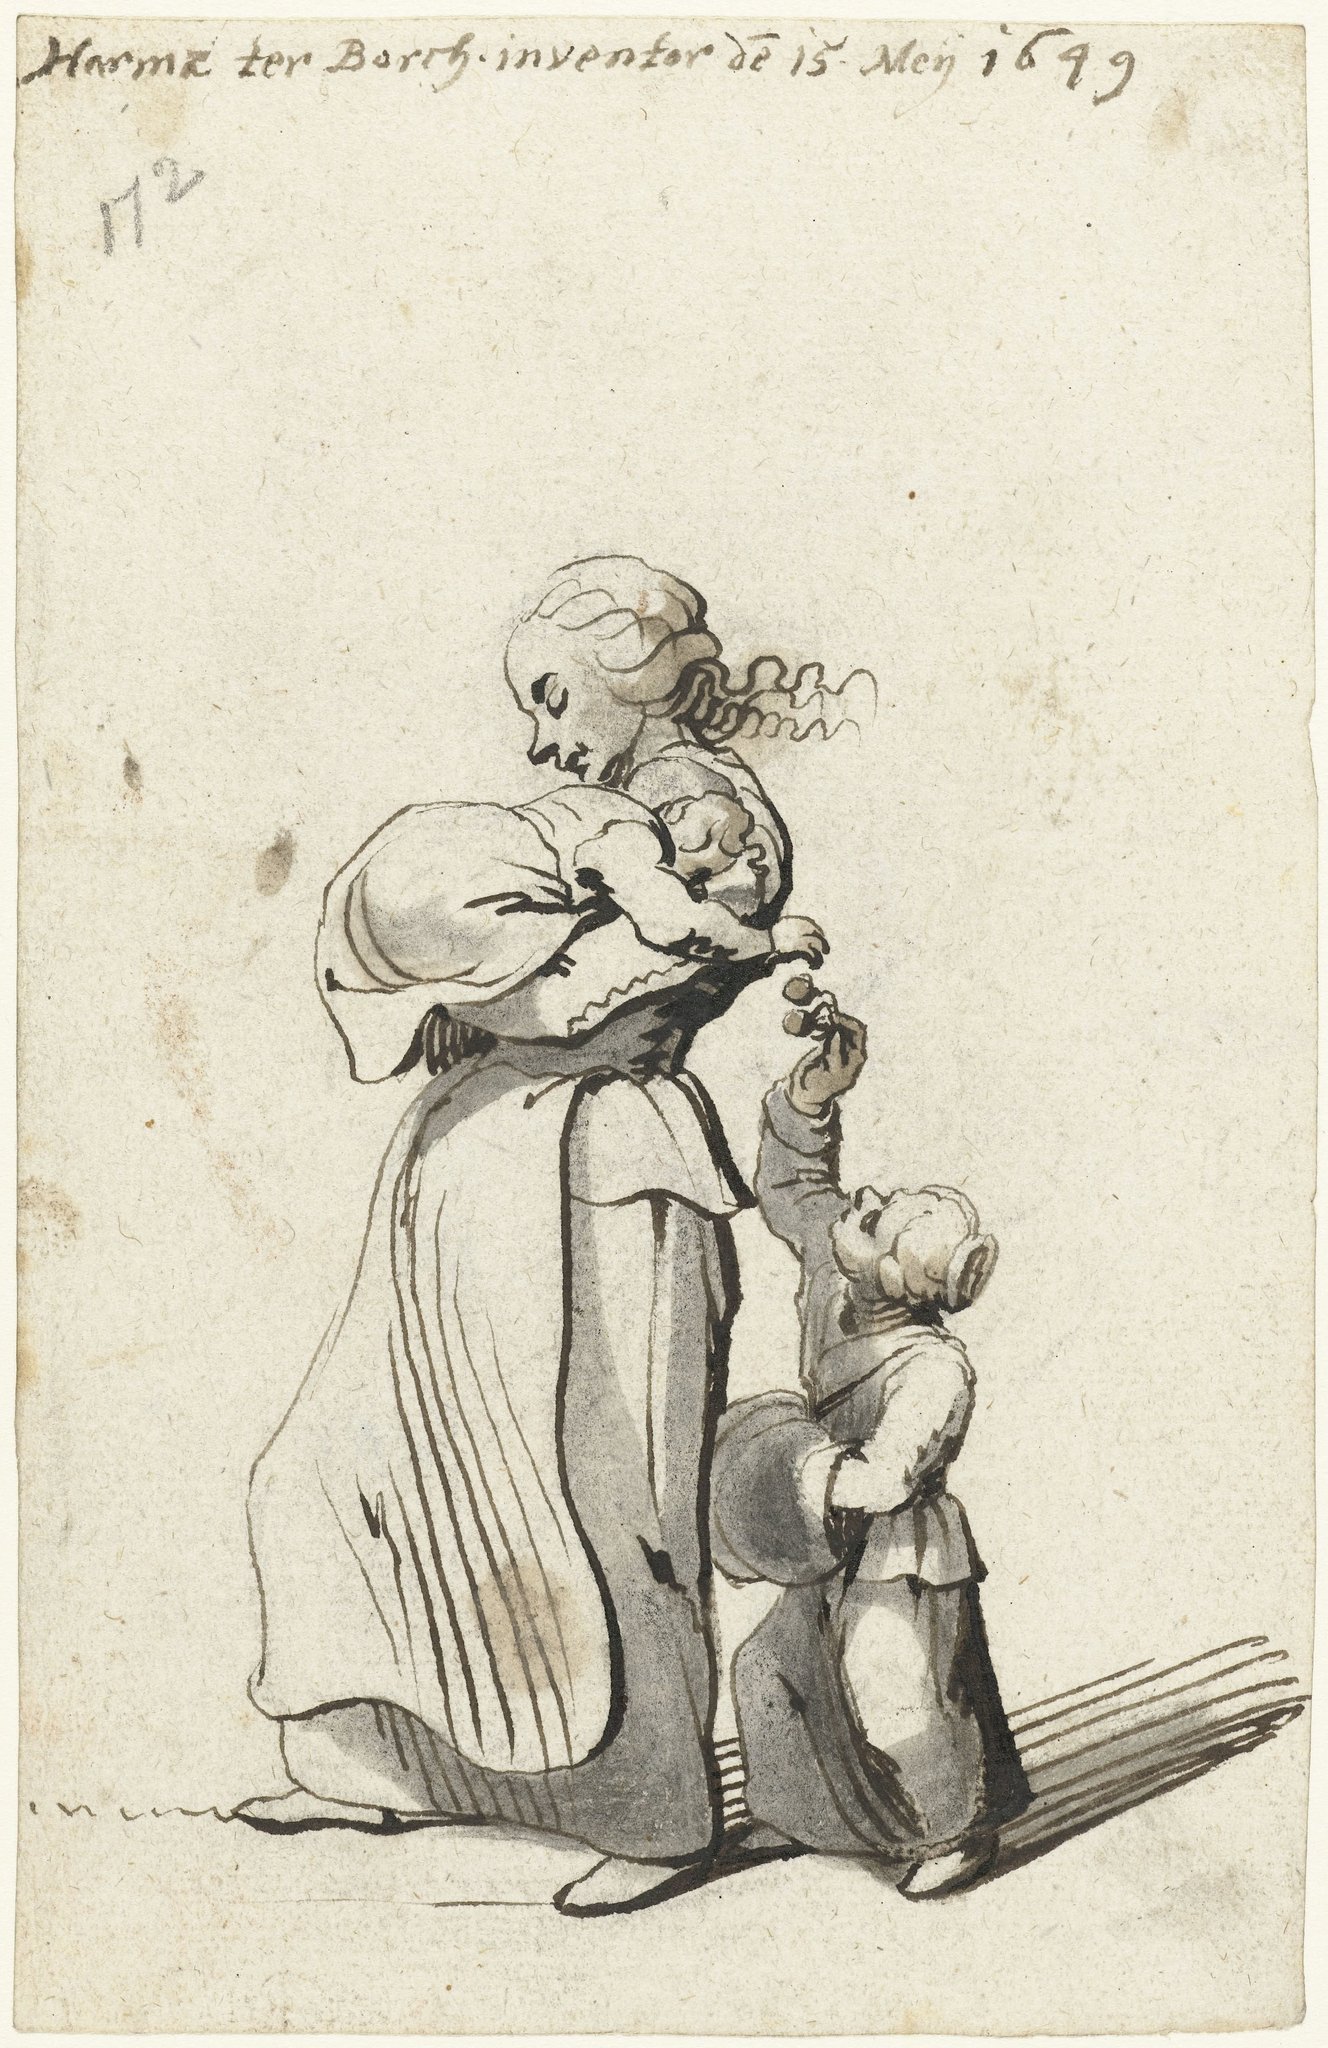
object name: drawing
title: Vrouw met een baby gevolgd door een kind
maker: harmen ter borch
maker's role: draughtsman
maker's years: 1638-1677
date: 1649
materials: chalk, ink, paper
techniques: brush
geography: zwolle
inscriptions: annotation: ‘Harma[n] ter Borch. inventor de[n] 15.Mey 1649’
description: Vrouw met een baby gevolgd door een kind dat kersen bij de baby houdt.